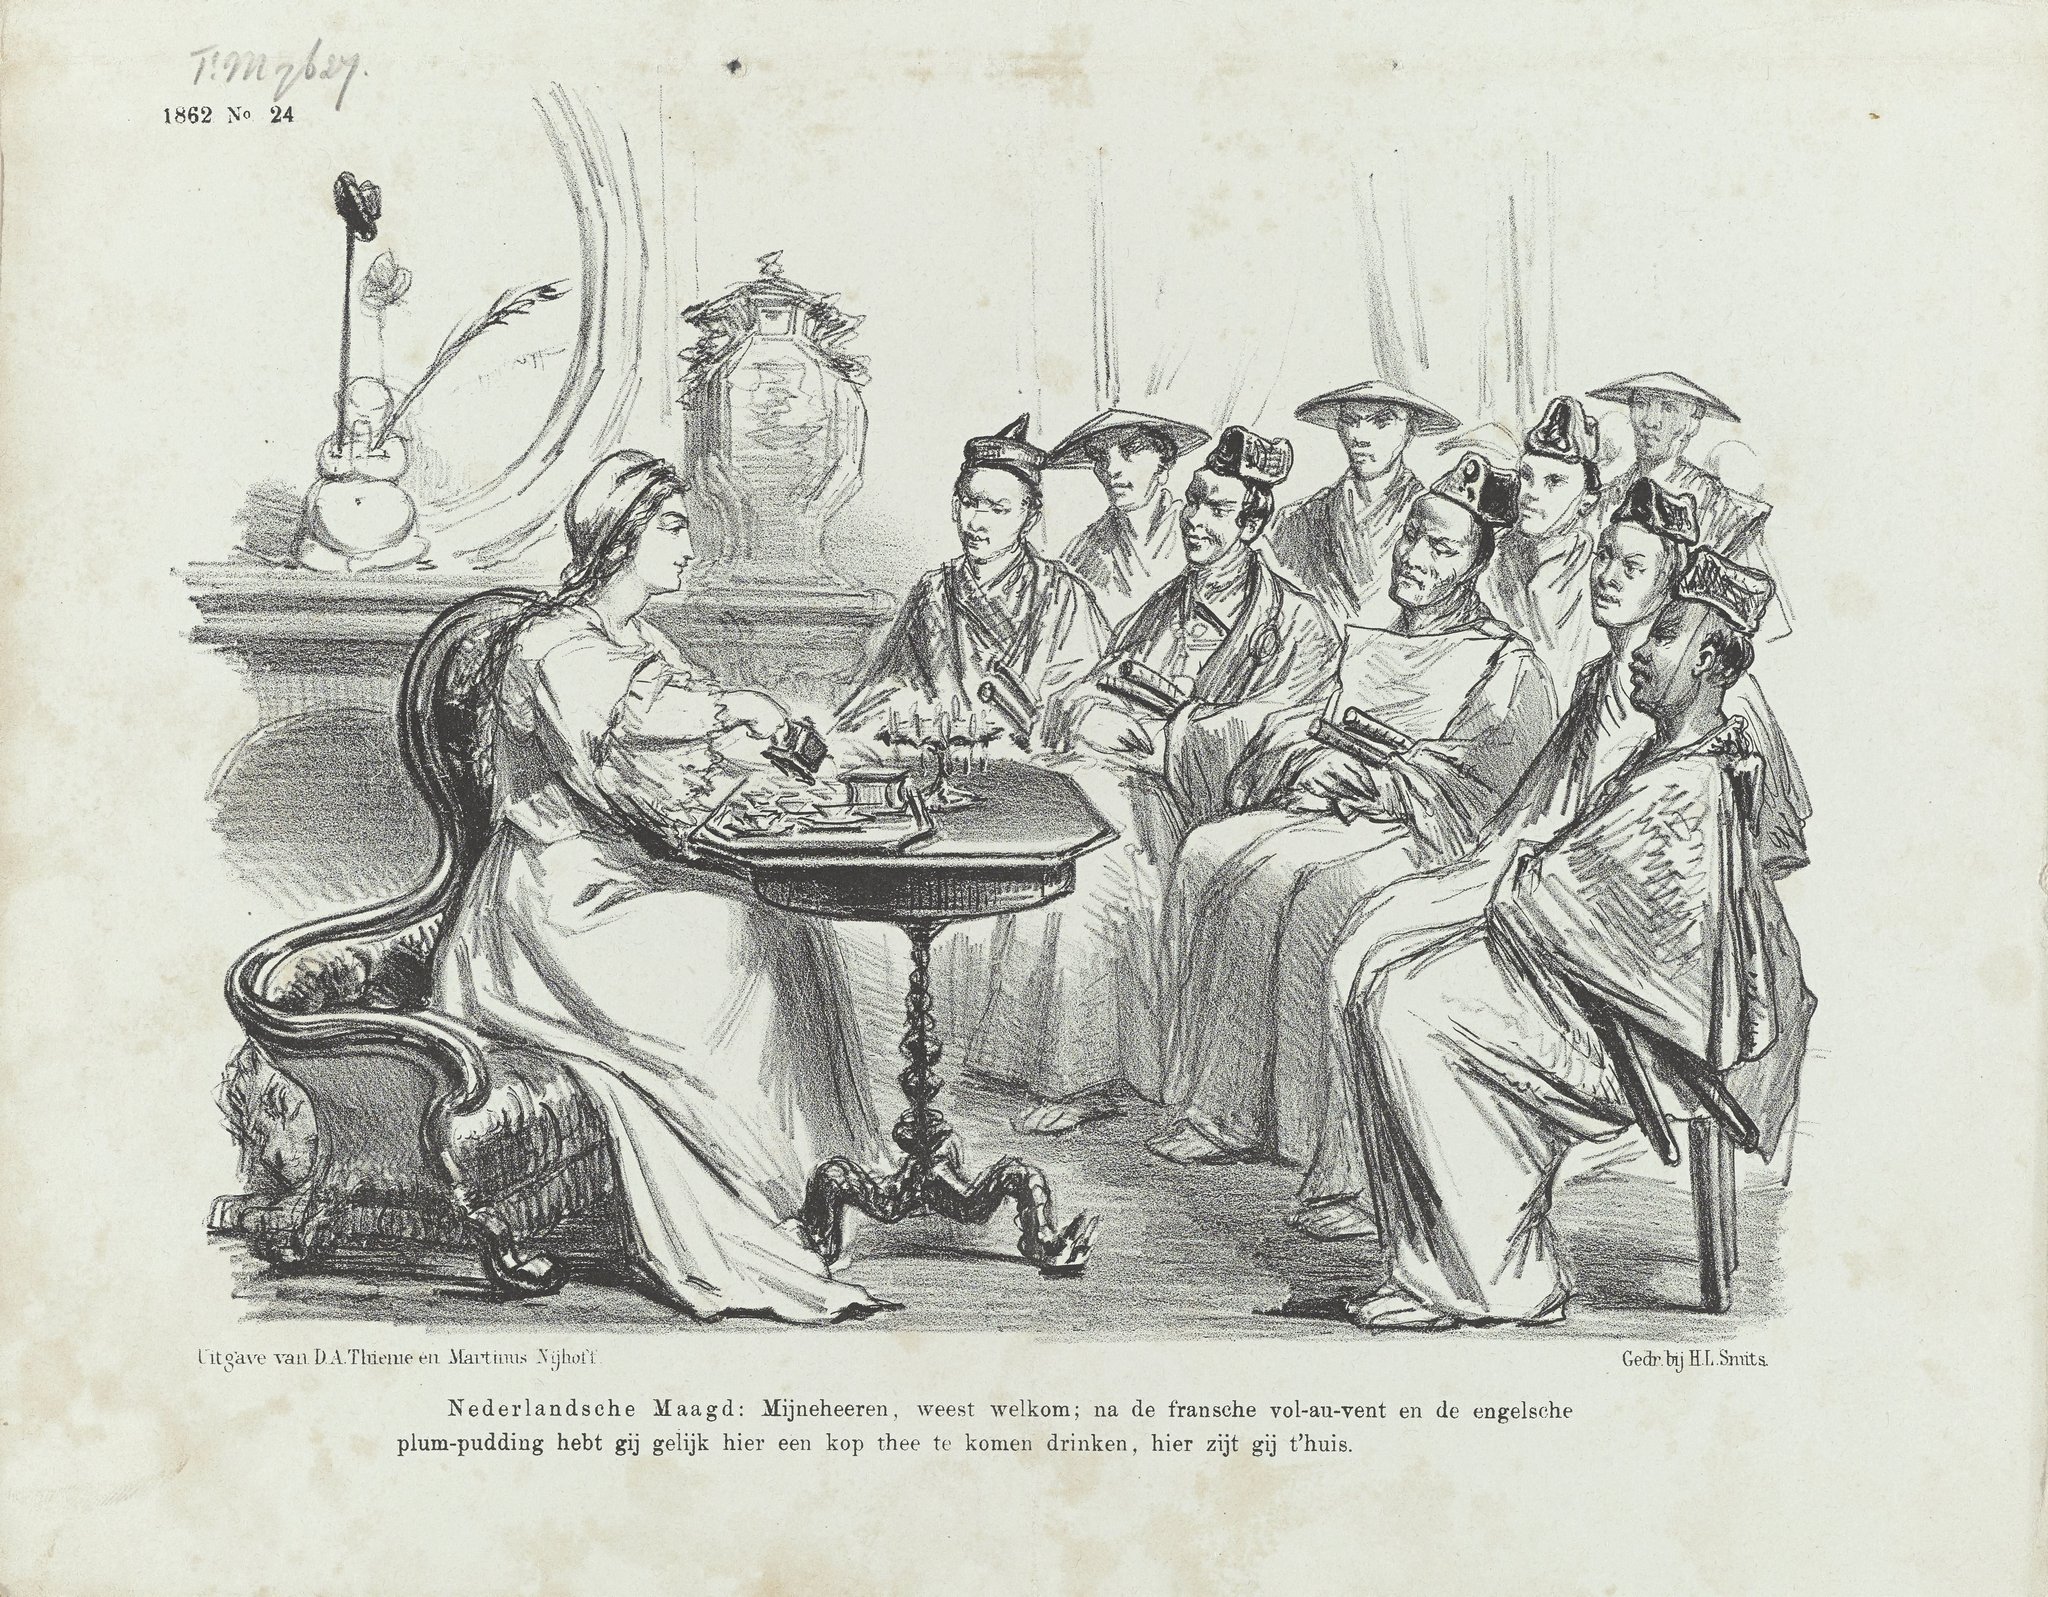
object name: print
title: Spotprent waarin de Nederlandse Maagd thee inschenkt voor het Japanse gezelschap, 1862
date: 1862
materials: paper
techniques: lithograph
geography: arnhem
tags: personifications of countries, nations, states, districts, etc., afternoon tea, cup of tea, japan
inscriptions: collector's mark: Lugt 2228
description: Spotprent waarin de Nederlandse Maagd thee inschenkt voor het Japanse gezelschap. Plaat verschenen bij het weekblad De Nederlandsche Spectator, nr. 24, 14 juni 1862.